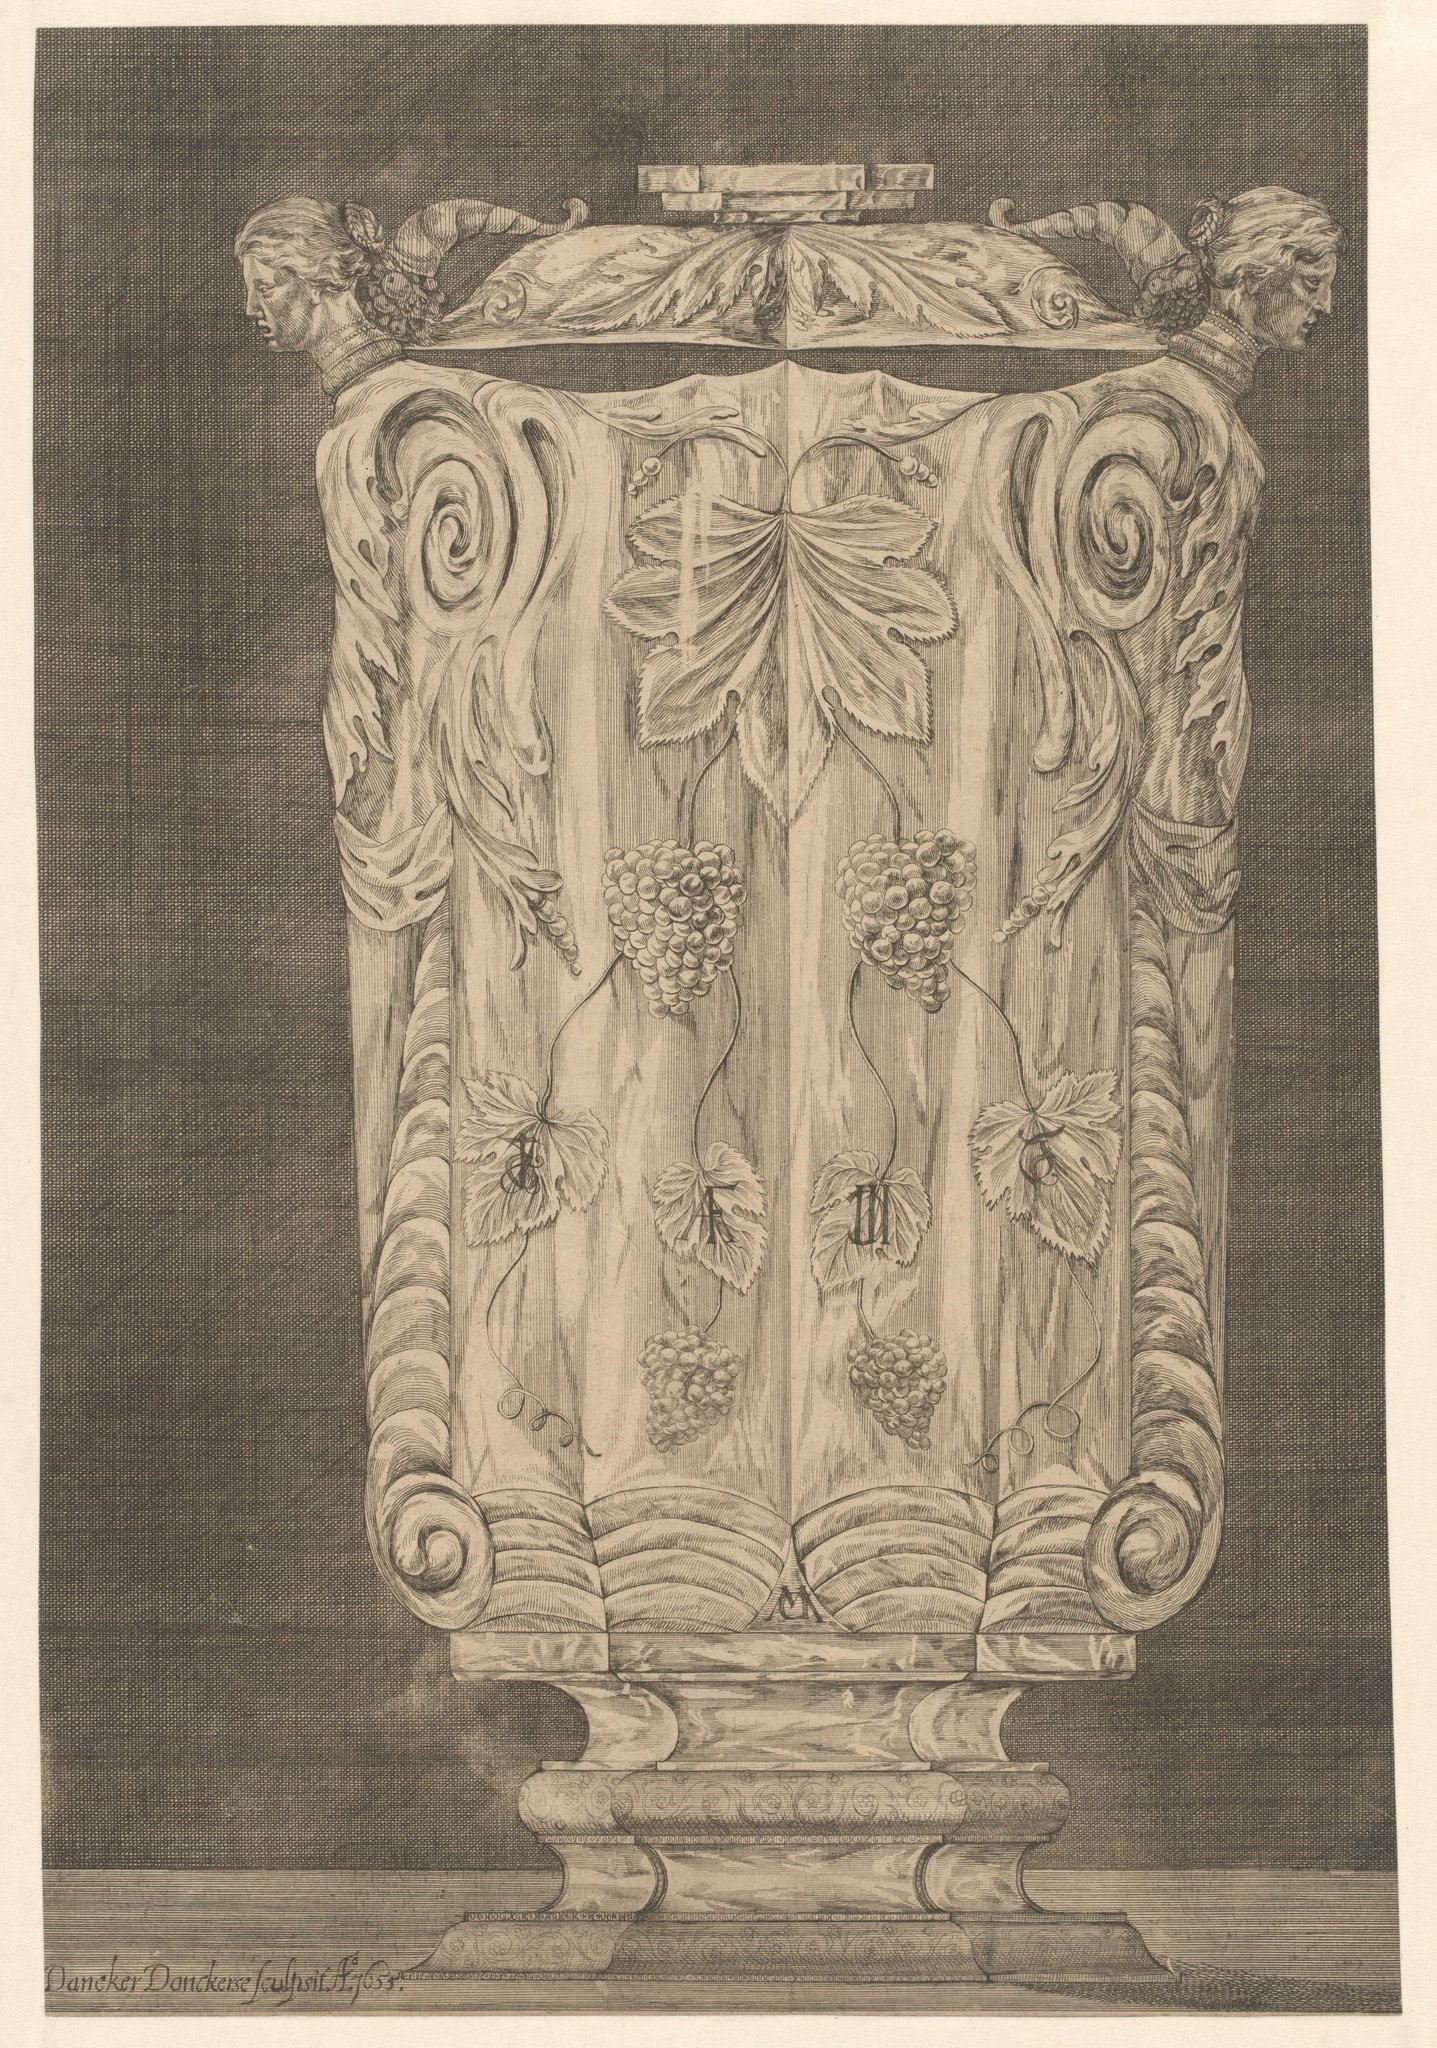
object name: print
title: Bergkristallen vaas, onderdeel van de 'Pyramide Miseroni'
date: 1655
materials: paper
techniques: engraving, etching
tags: container of (semi-)precious stone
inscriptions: collector's mark: Lugt 2760, collector's mark: Lugt 2228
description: De bergkristallen vaas die een onderdeel vormt van de zogenaamde 'Pyramide van Miseroni', vervaardigd in Praag door Dionysio Miseroni voor keizer Ferdinand III (Kunsthistorisches Museum, Wenen). Zie ook de vermoedelijke pendant. Onderste marge met tekst is afgesneden.